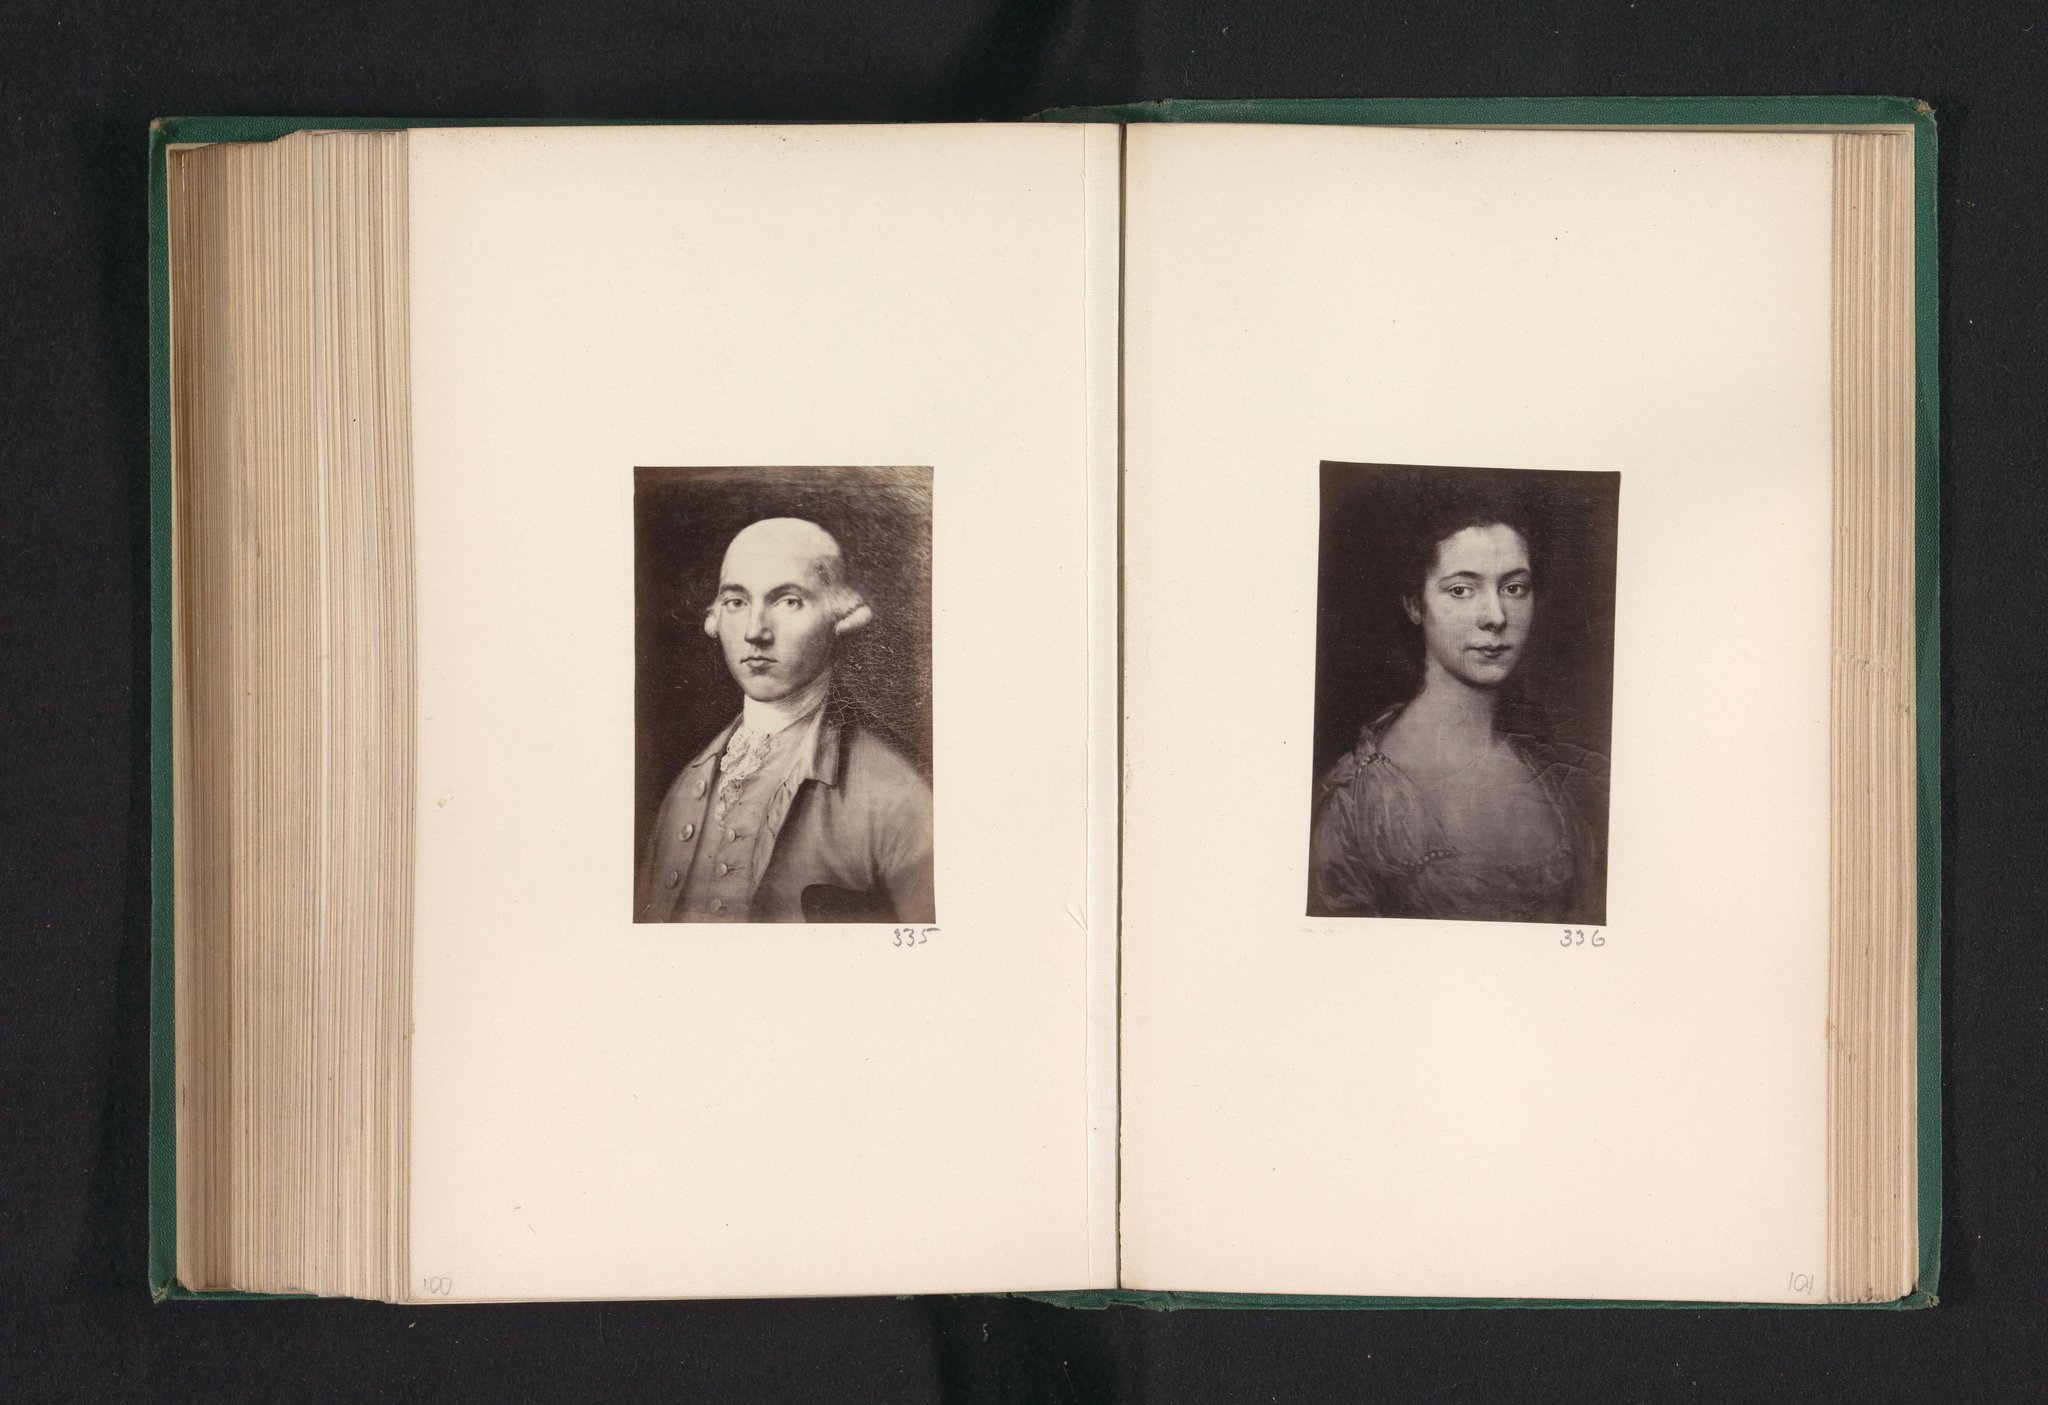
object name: page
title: Fotoreproductie van een schilderij, voorstellende een portret van Margaret Smythe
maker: thomas annan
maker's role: fotograaf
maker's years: 1829-1887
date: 1863-1868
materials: photographic support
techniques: albumen print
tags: anonymous historical person portrayed (+ (full) bust portrait)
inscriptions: number: ‘336’